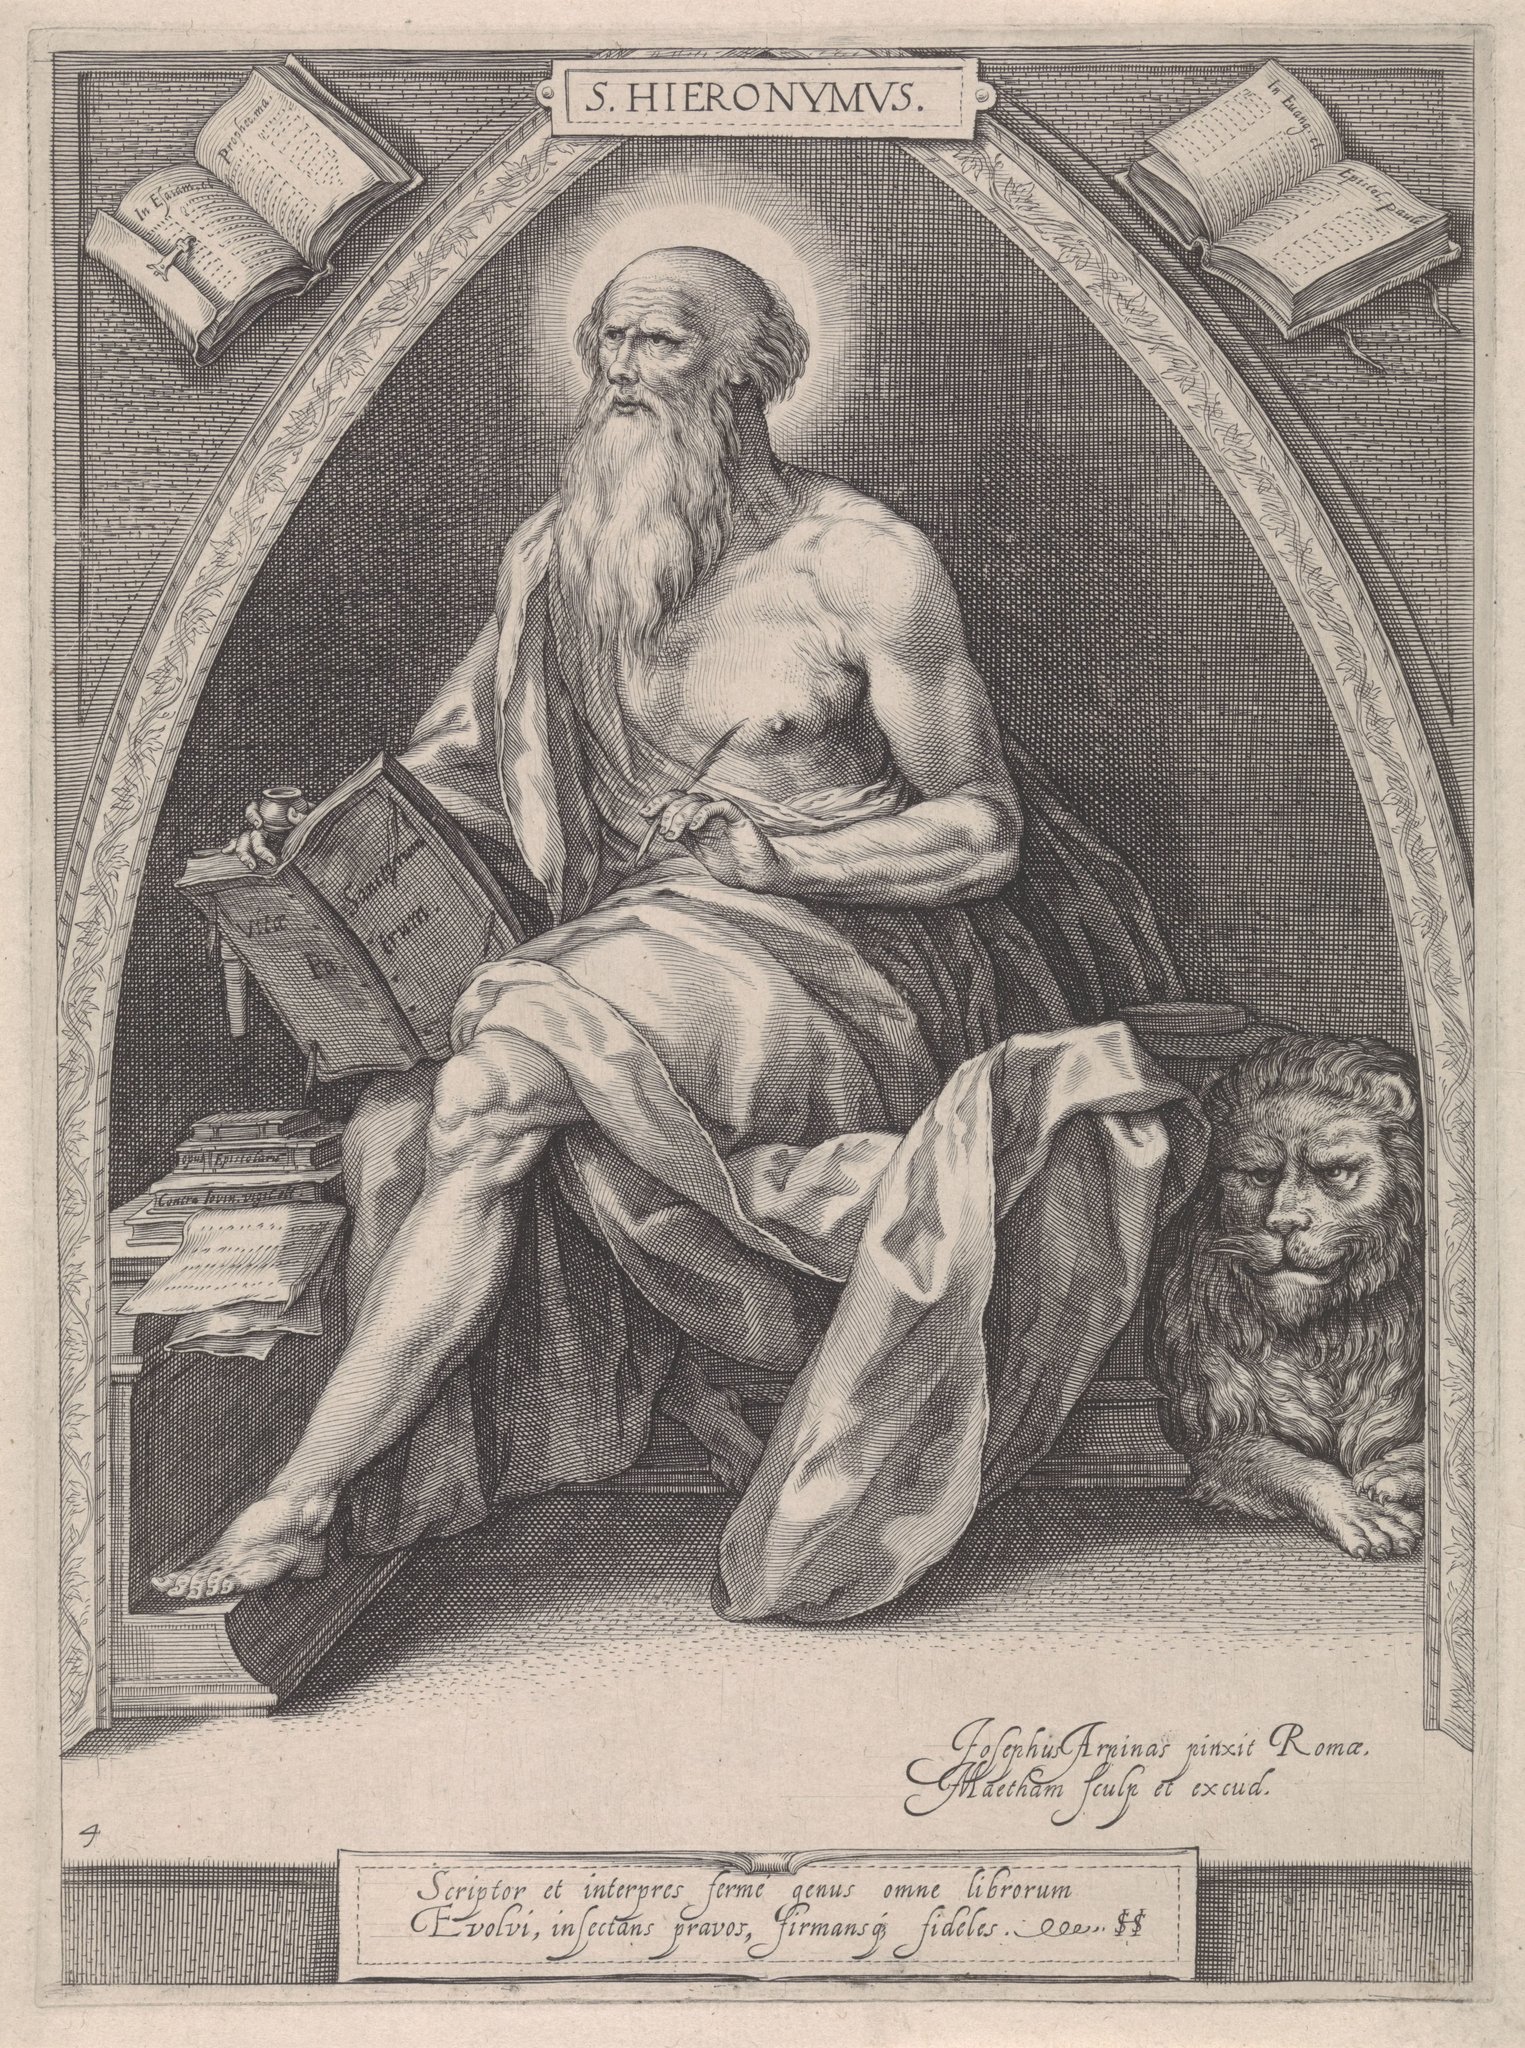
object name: print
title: Vier kerkvaders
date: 1600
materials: paper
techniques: engraving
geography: haarlem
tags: st. jerome as doctor of the latin church in his study with book, pen and ink; lion and cardinal's hat beside him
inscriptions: collector's mark: Lugt 240